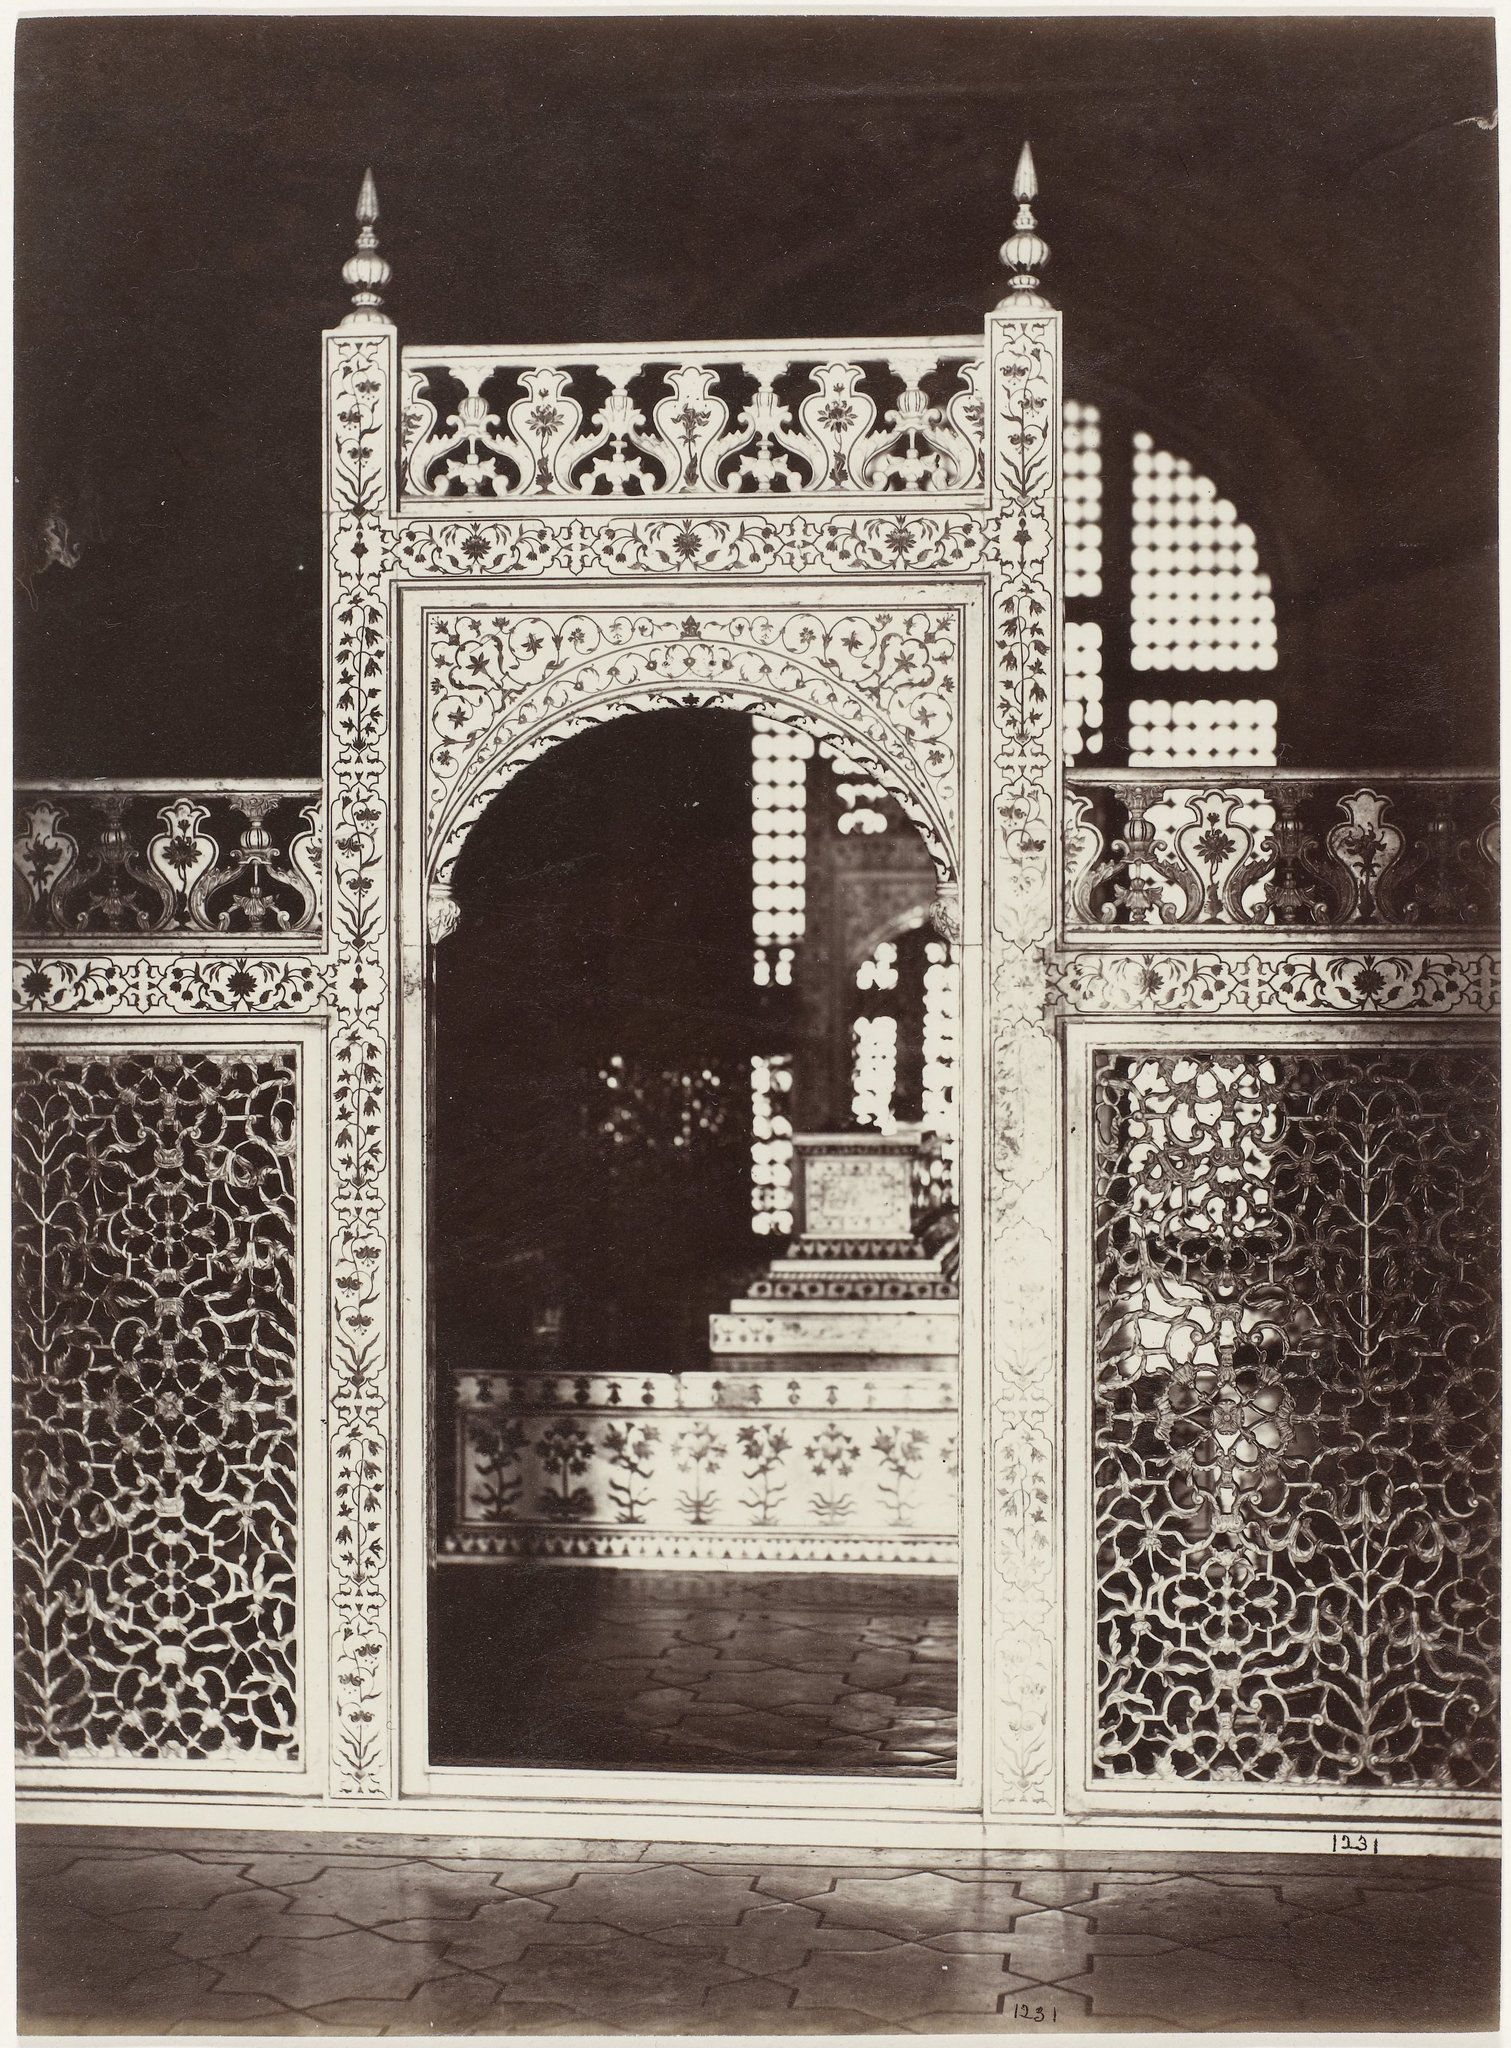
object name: photograph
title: The screen enclosing the sarcophagi in the interior of the Taj Mahal, Agra, Uttar Pradesh, India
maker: samuel bourne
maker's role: fotograaf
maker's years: 1834-1912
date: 1865-1866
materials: paper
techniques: albumen print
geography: taj mahal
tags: carving ~ applied arts, fence, wall, paling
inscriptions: number: ‘1231/ 1231’